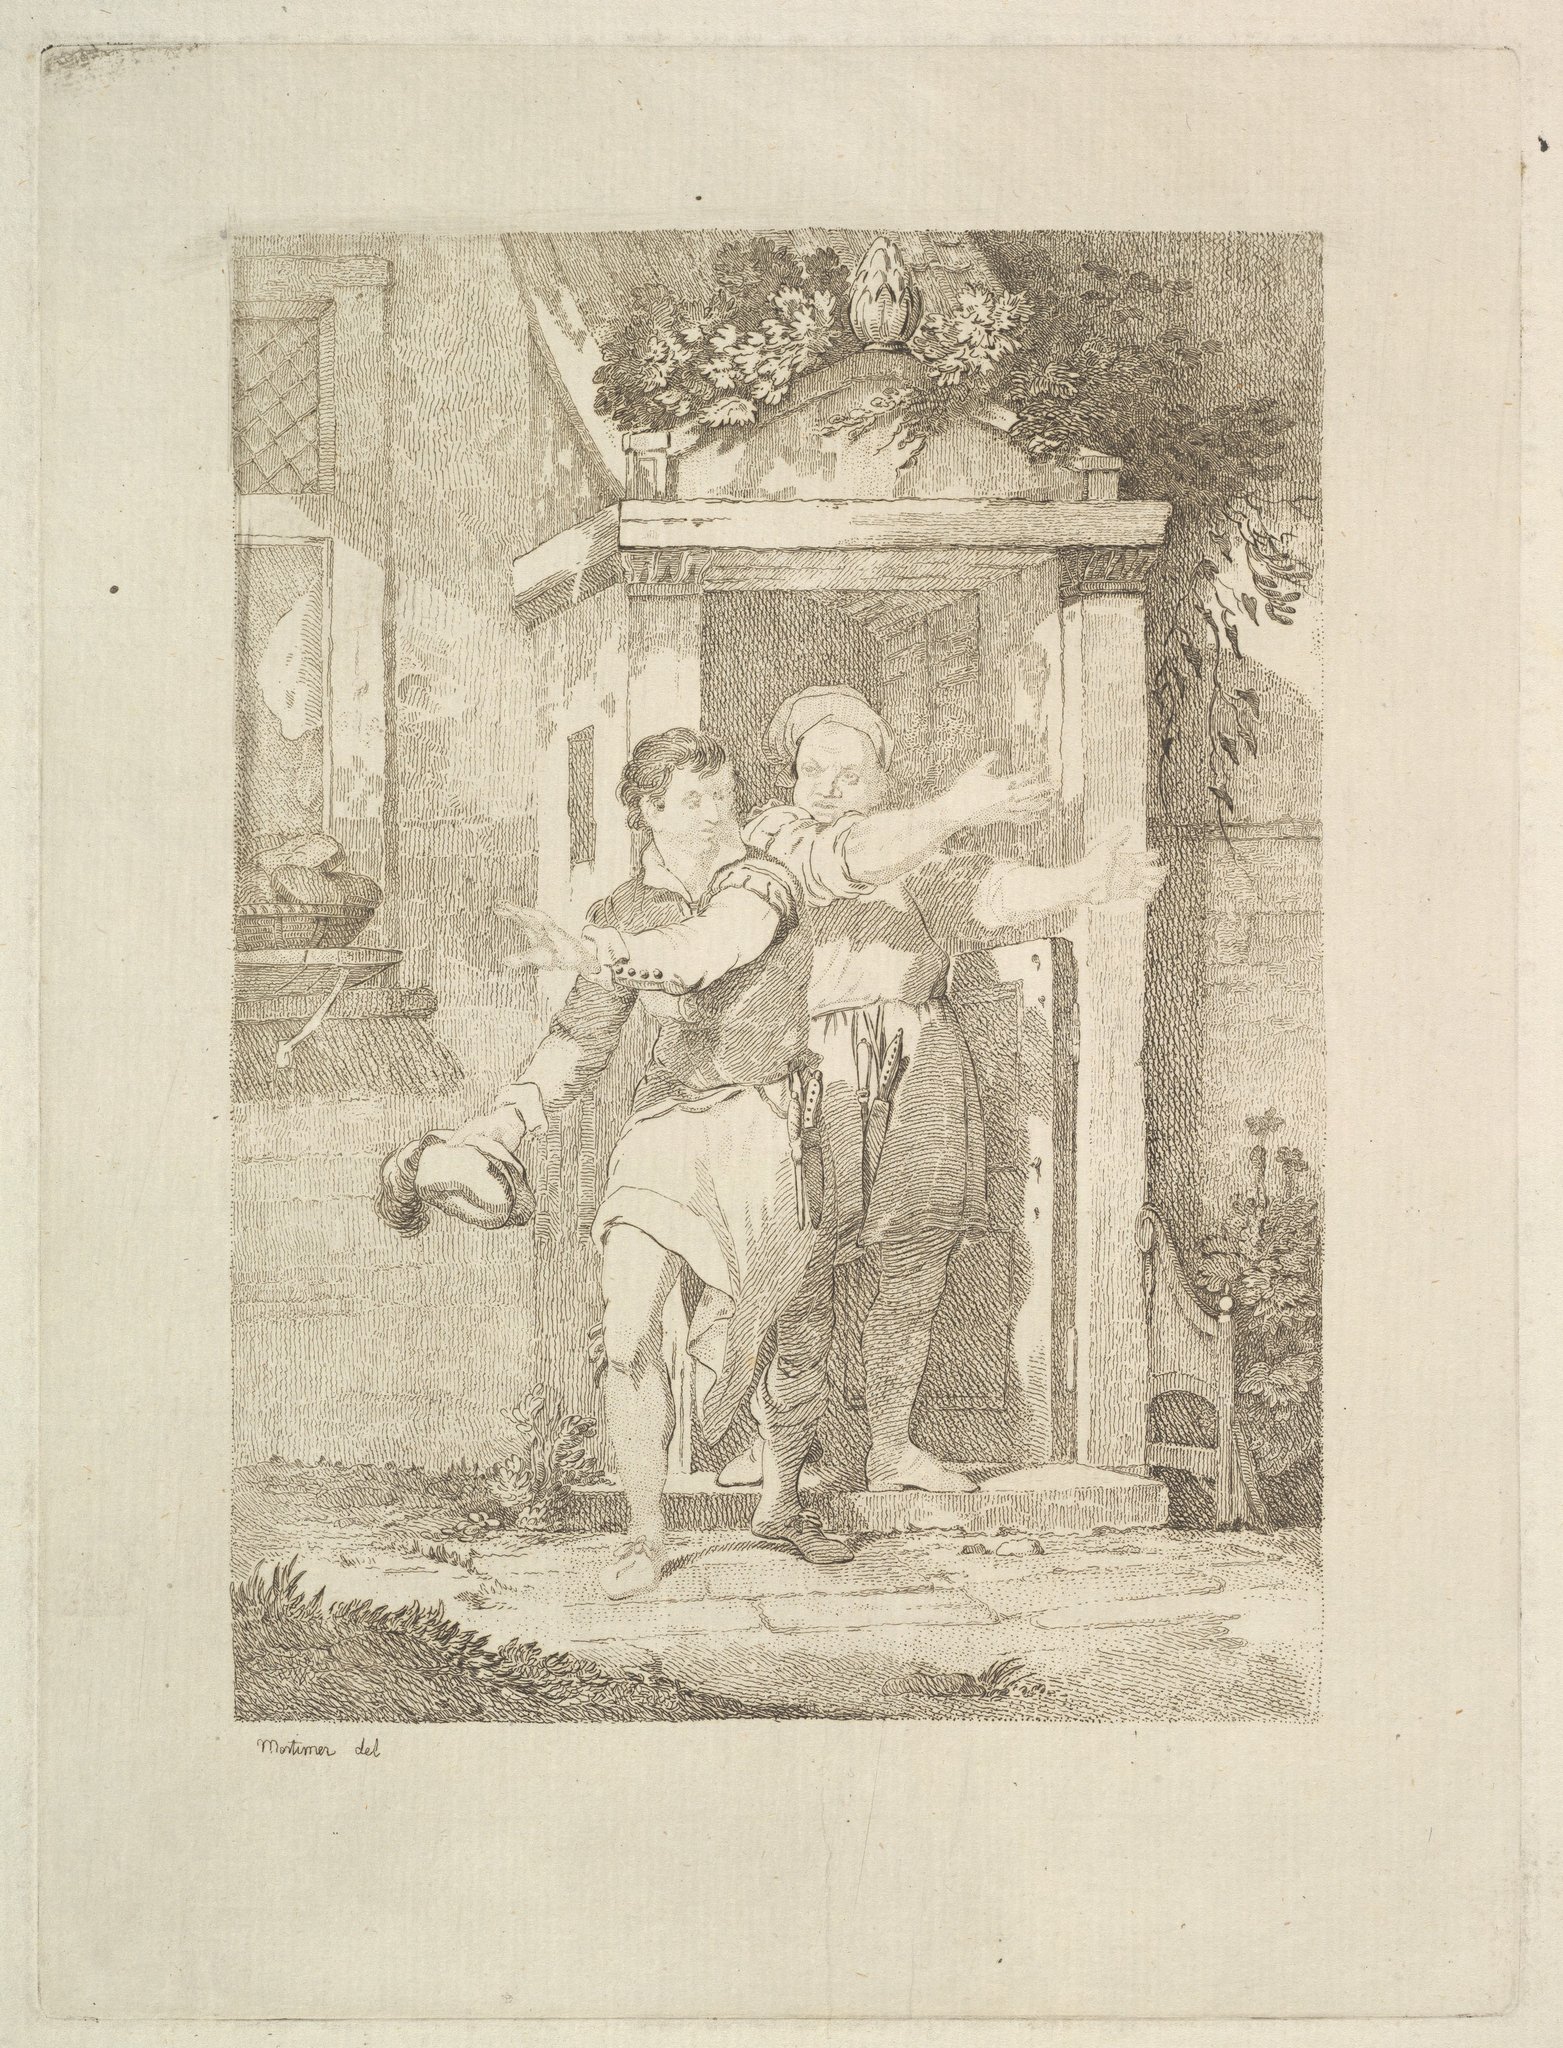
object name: print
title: The Coke and Perkin (The Cook's Tale, Chaucer's Canterbury Tales)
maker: francis chesham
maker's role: artist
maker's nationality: british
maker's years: 1749-1806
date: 1767-1800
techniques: engraving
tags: men